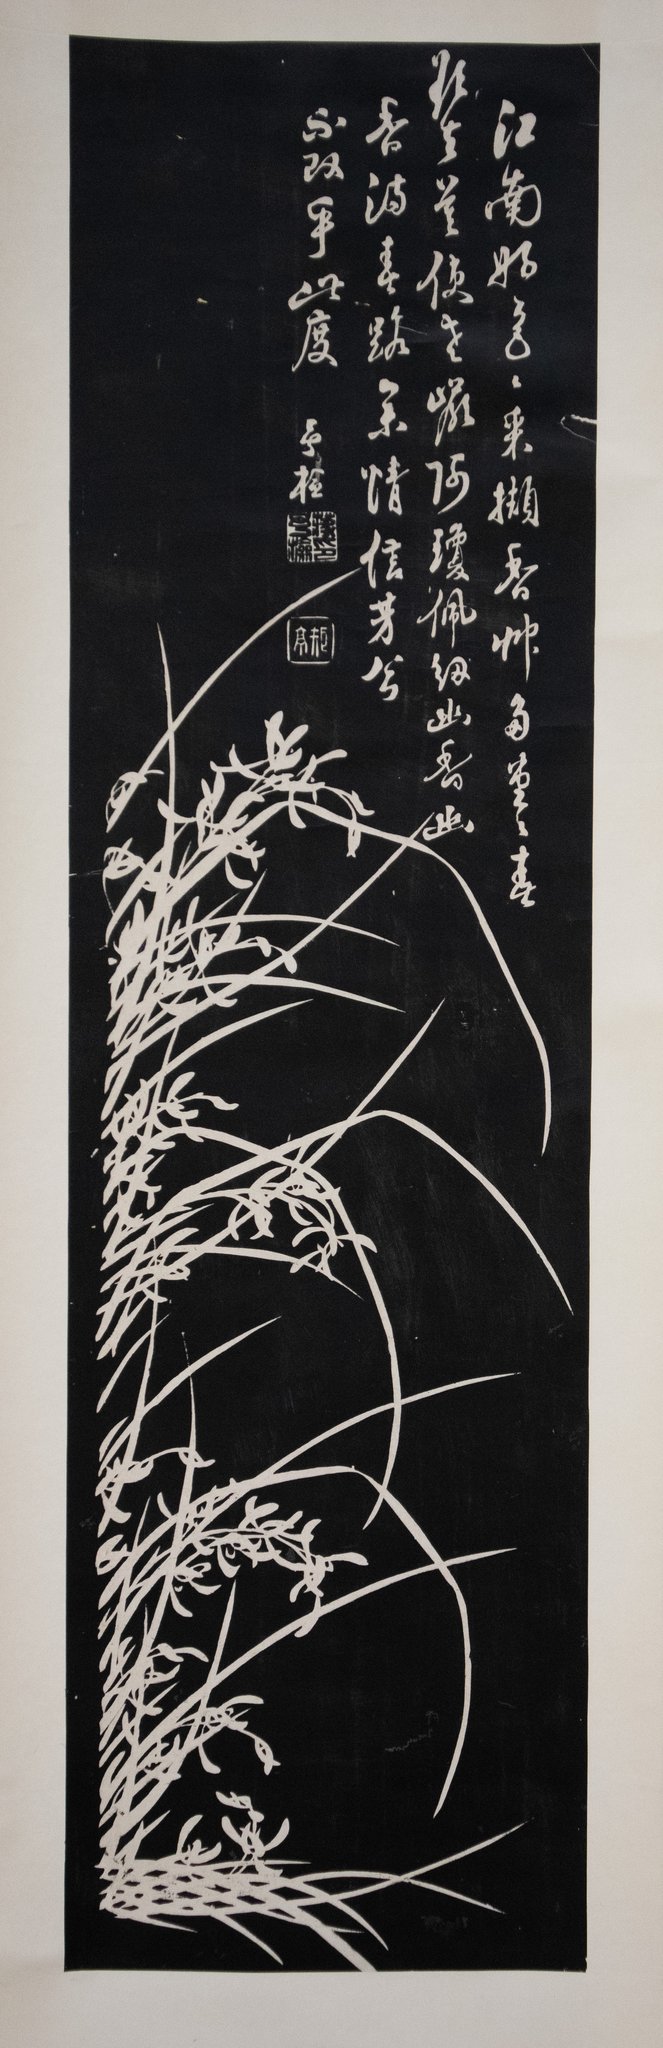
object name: print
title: Orchids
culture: chinese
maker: zhang yujian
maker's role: artist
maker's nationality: chinese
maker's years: 1736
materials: ink, paper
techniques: polychrome, woodblock print